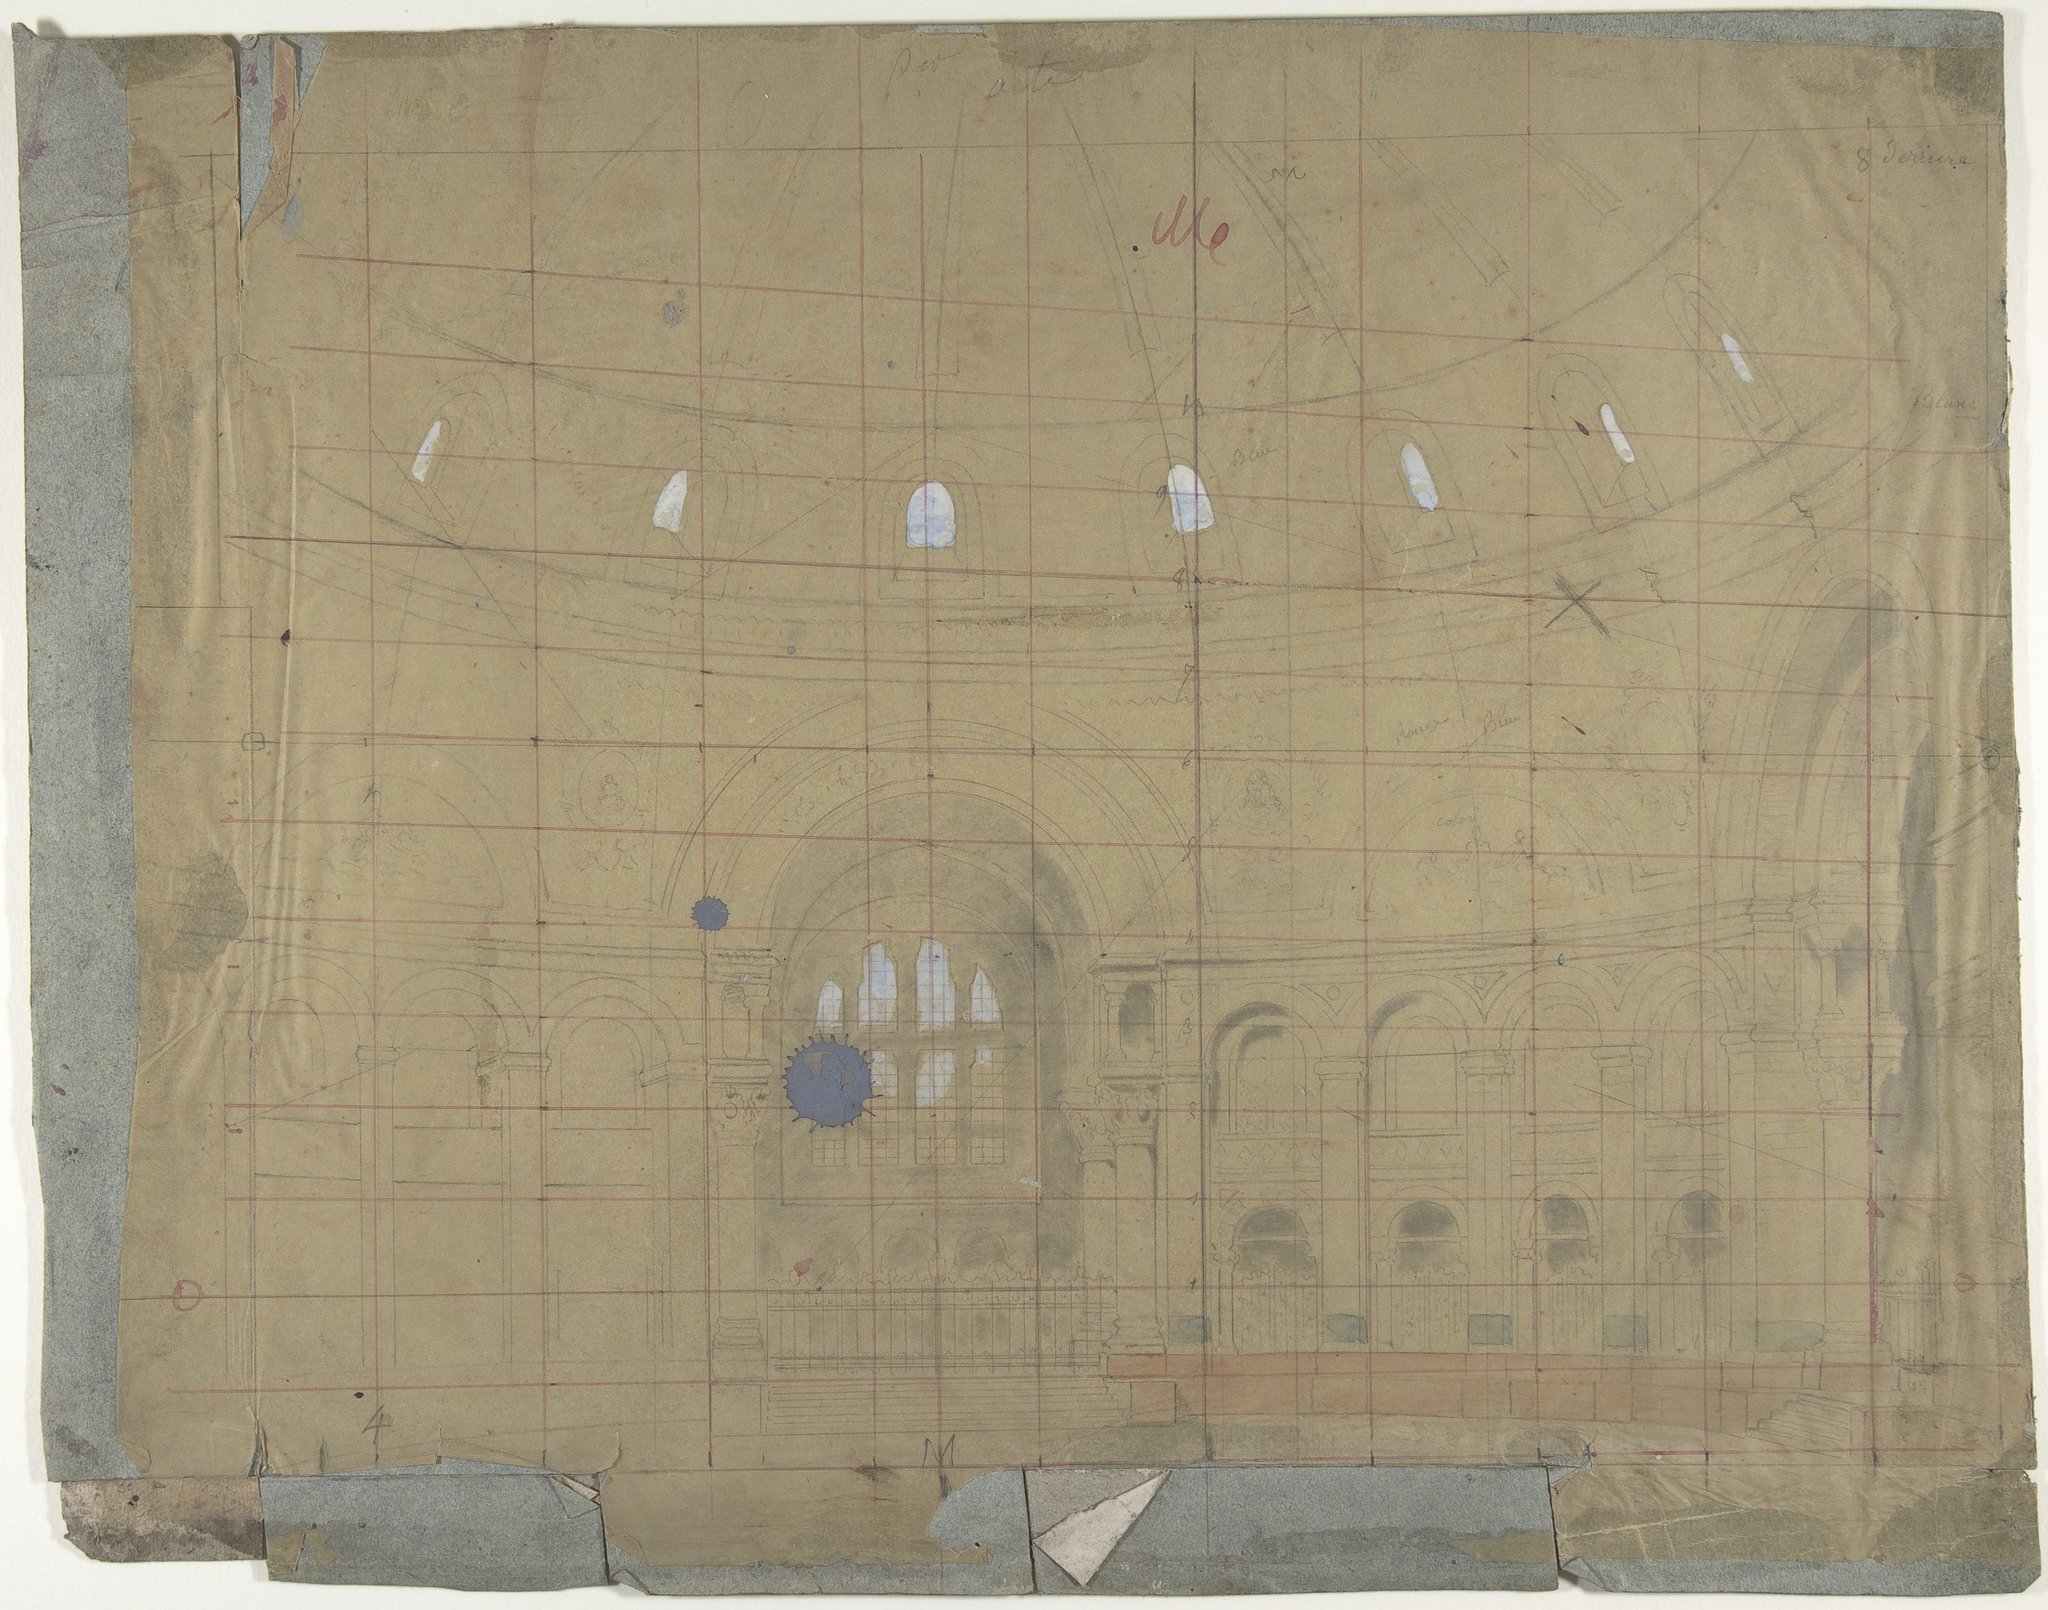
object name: drawing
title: Design for a Stage Set at the Opéra, Paris: Church Interior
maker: eugène cicéri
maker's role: artist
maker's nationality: french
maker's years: 1813-1890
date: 1830-1890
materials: gouache, graphite, ink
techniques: pen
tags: interiors,churches,stage design